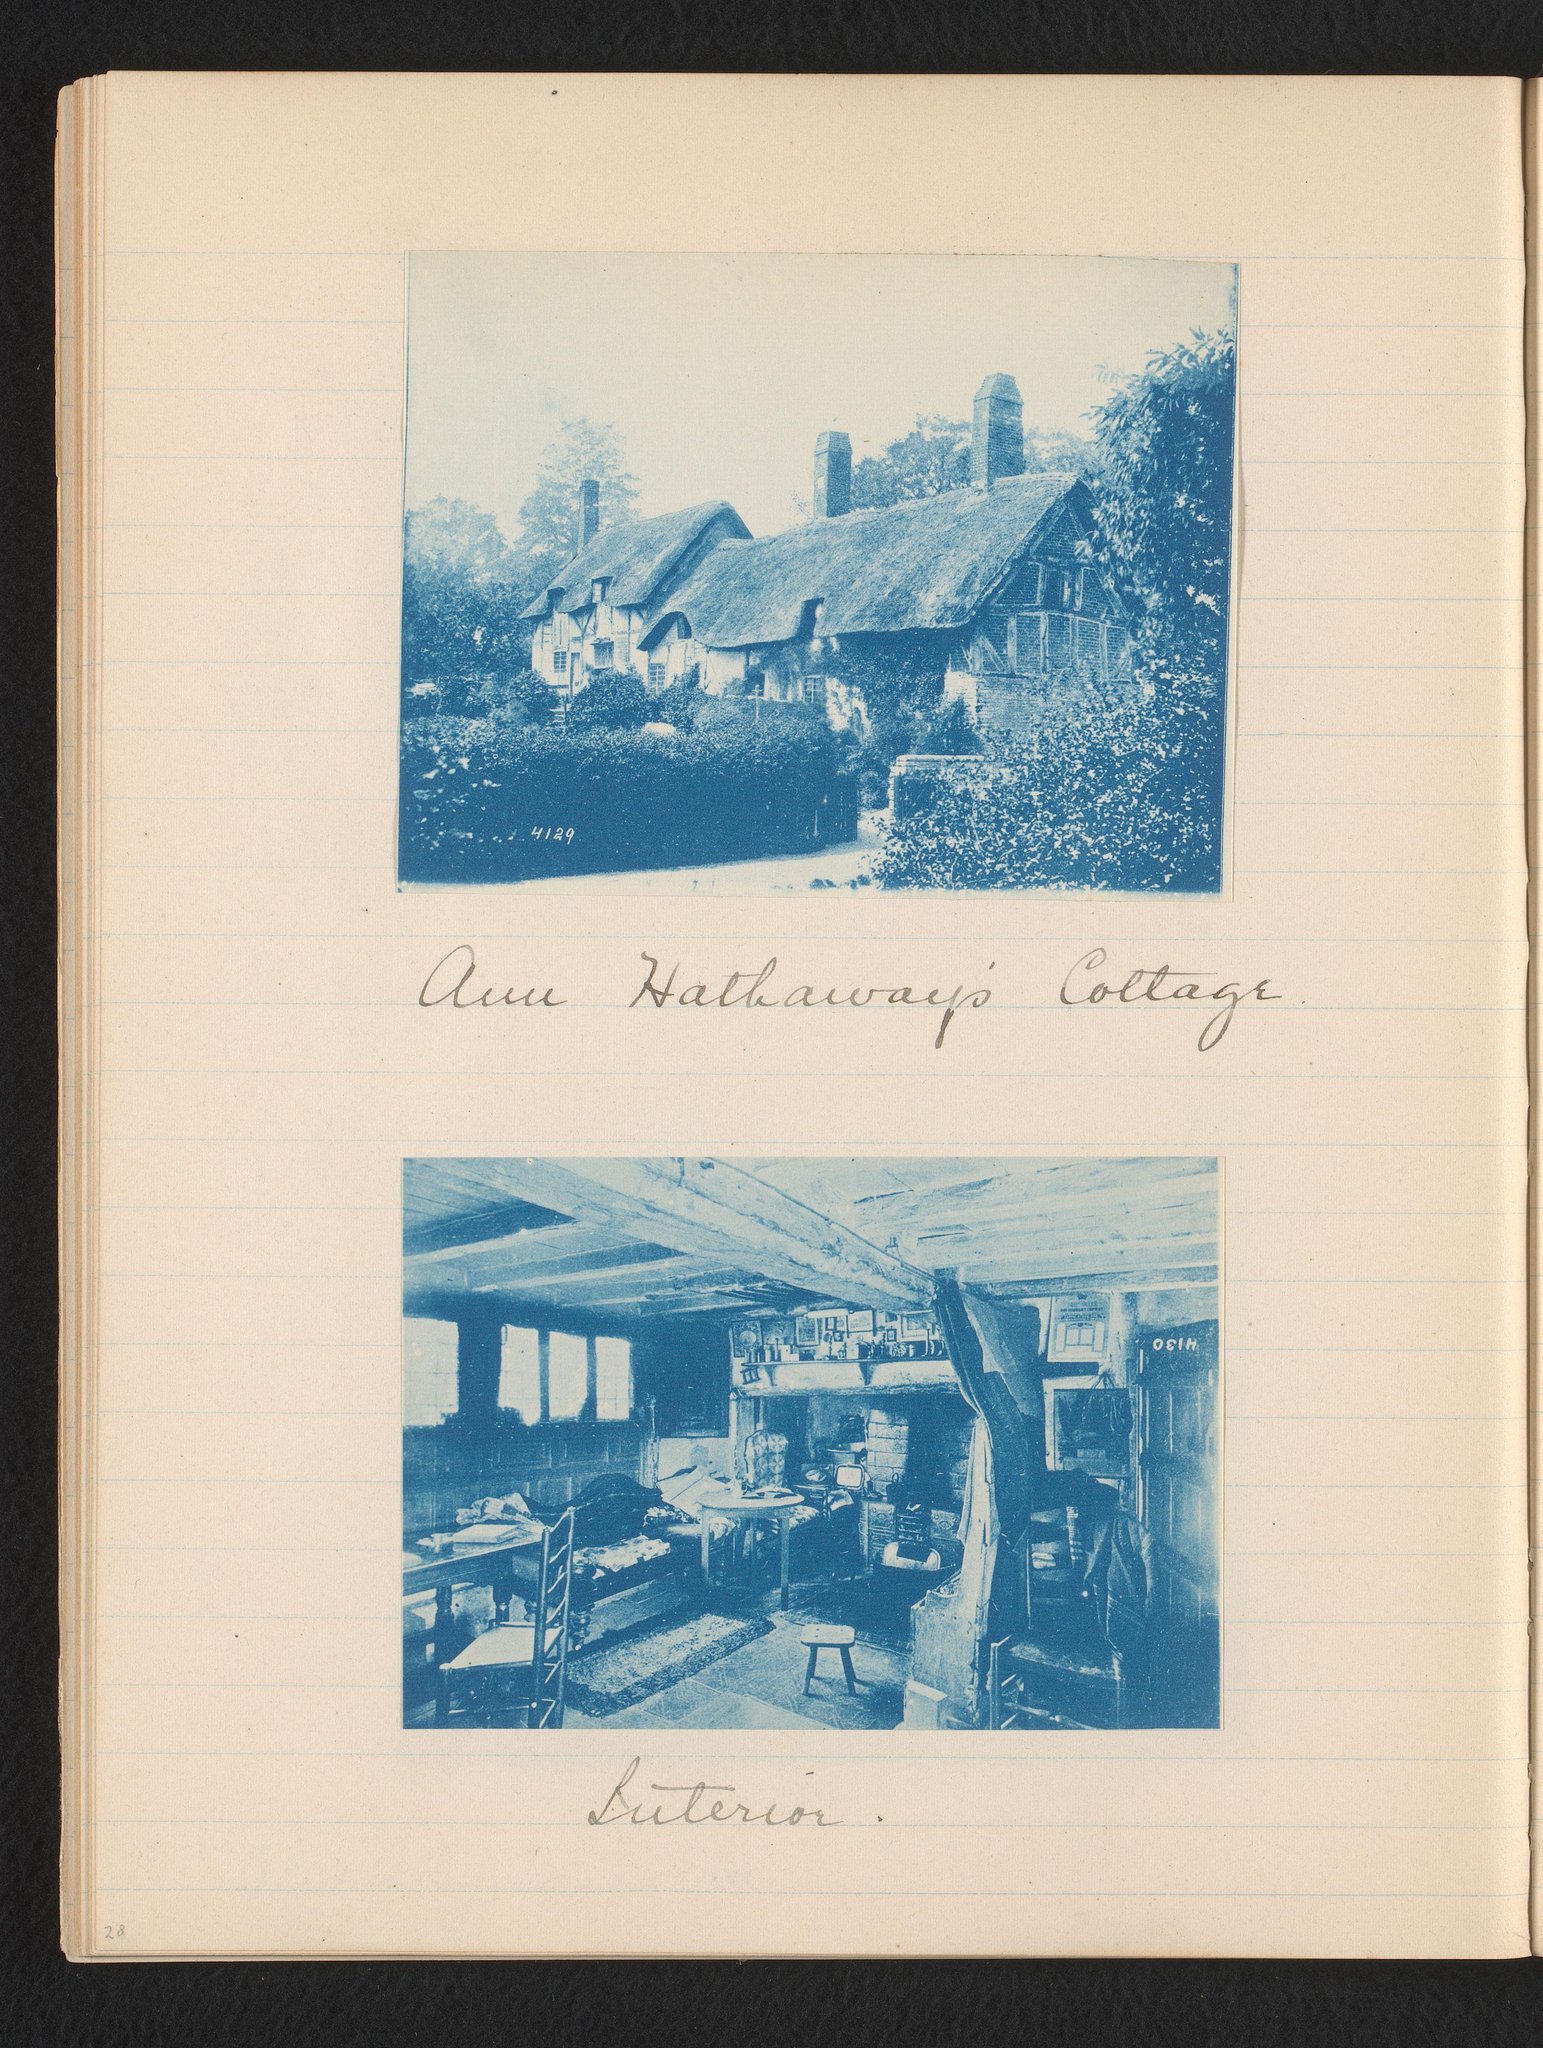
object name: album leaf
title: Twee foto's van het exterieur en interieur van de cottage van Anne Hathaway, Stratford-upon-Avon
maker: Anonymous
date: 1901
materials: paper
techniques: cyanotype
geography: stratford-upon-avon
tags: cottage, living-room, parlour, sitting-room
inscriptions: inscription: ‘Ann Hathaway's Cottage/ Interior’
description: Deze foto's maken deel uit van een album.